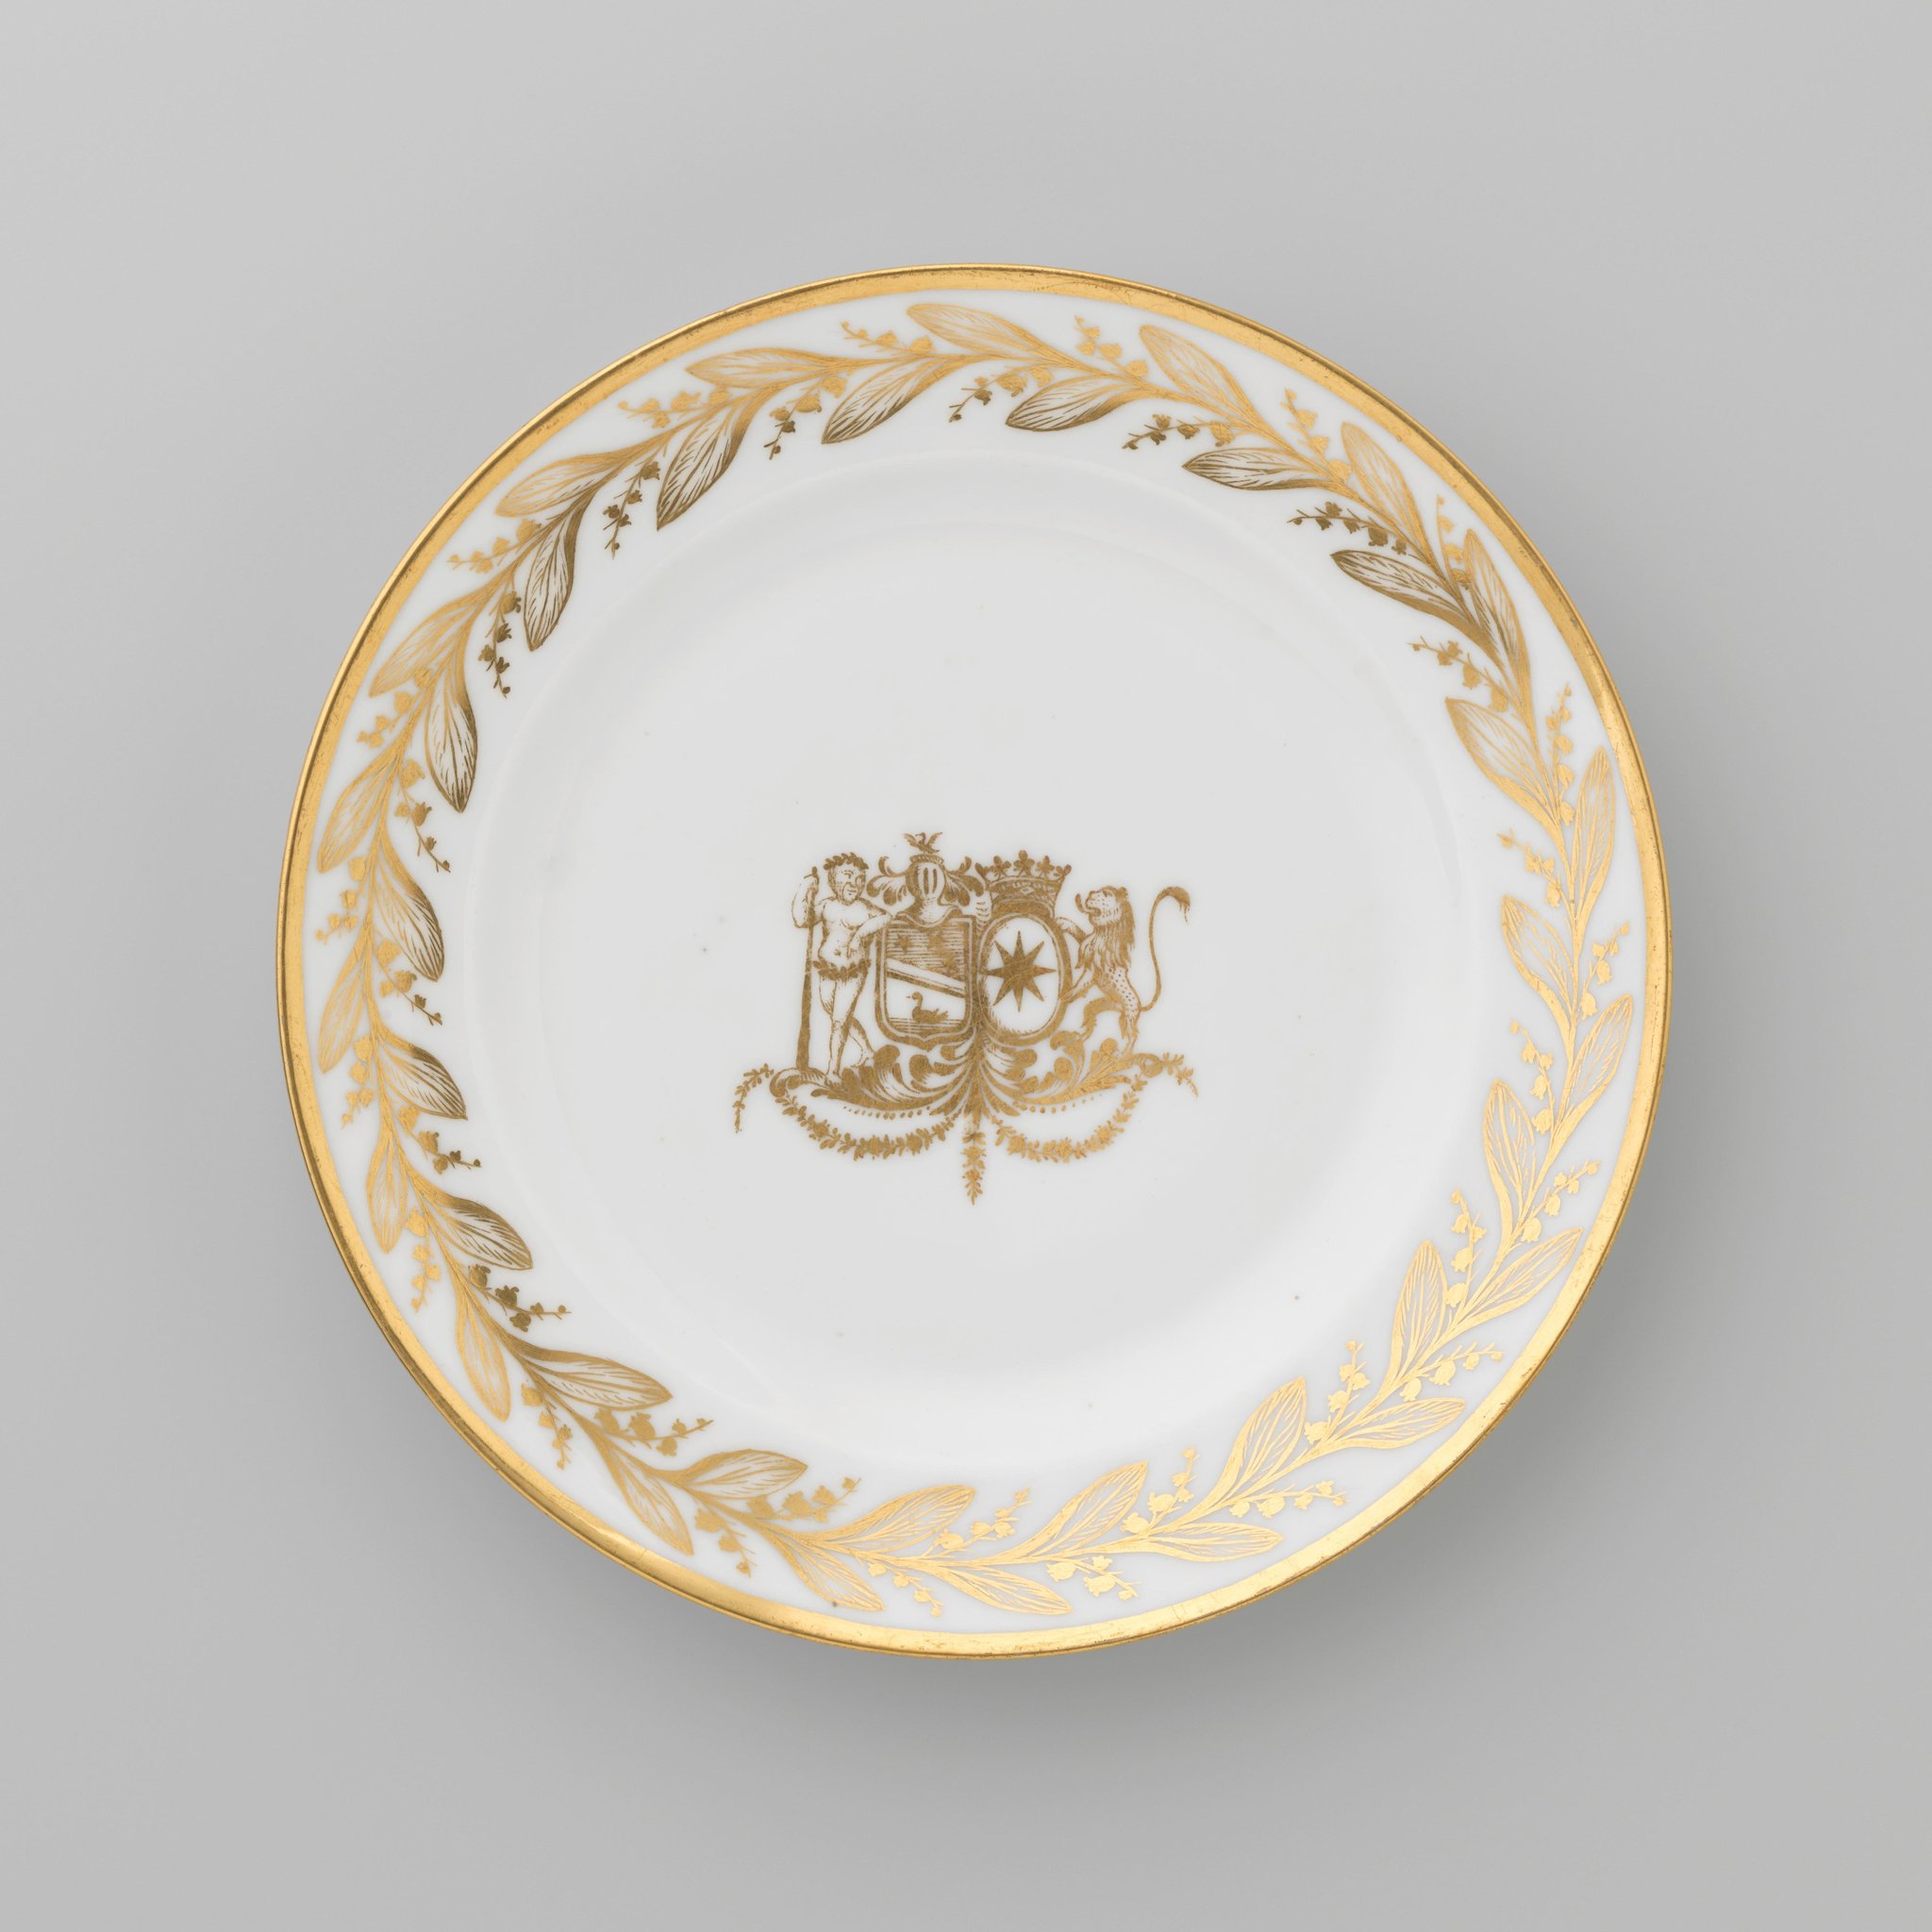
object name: plate dish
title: Plate with the coat of arms of Hendrik Peter Godfried Quack and Isabella Gertraud von Carnap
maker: Anonymous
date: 1790-1800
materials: glaze, gold, paint, porcelain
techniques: firing, forming, gilding, turning, vitrification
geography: paris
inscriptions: mark: ‘N of P’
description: Bord van porselein, beschilderd op het glazuur met goud. Op het plat het alliantiewapen van Hendrik Peter Godfried Quack en Isabella Gertraud von Carnap. De rand met een bloemrank en een gouden band. Drie proenen op de onderzijde. Gemerkt op de onderzijde met N of P.